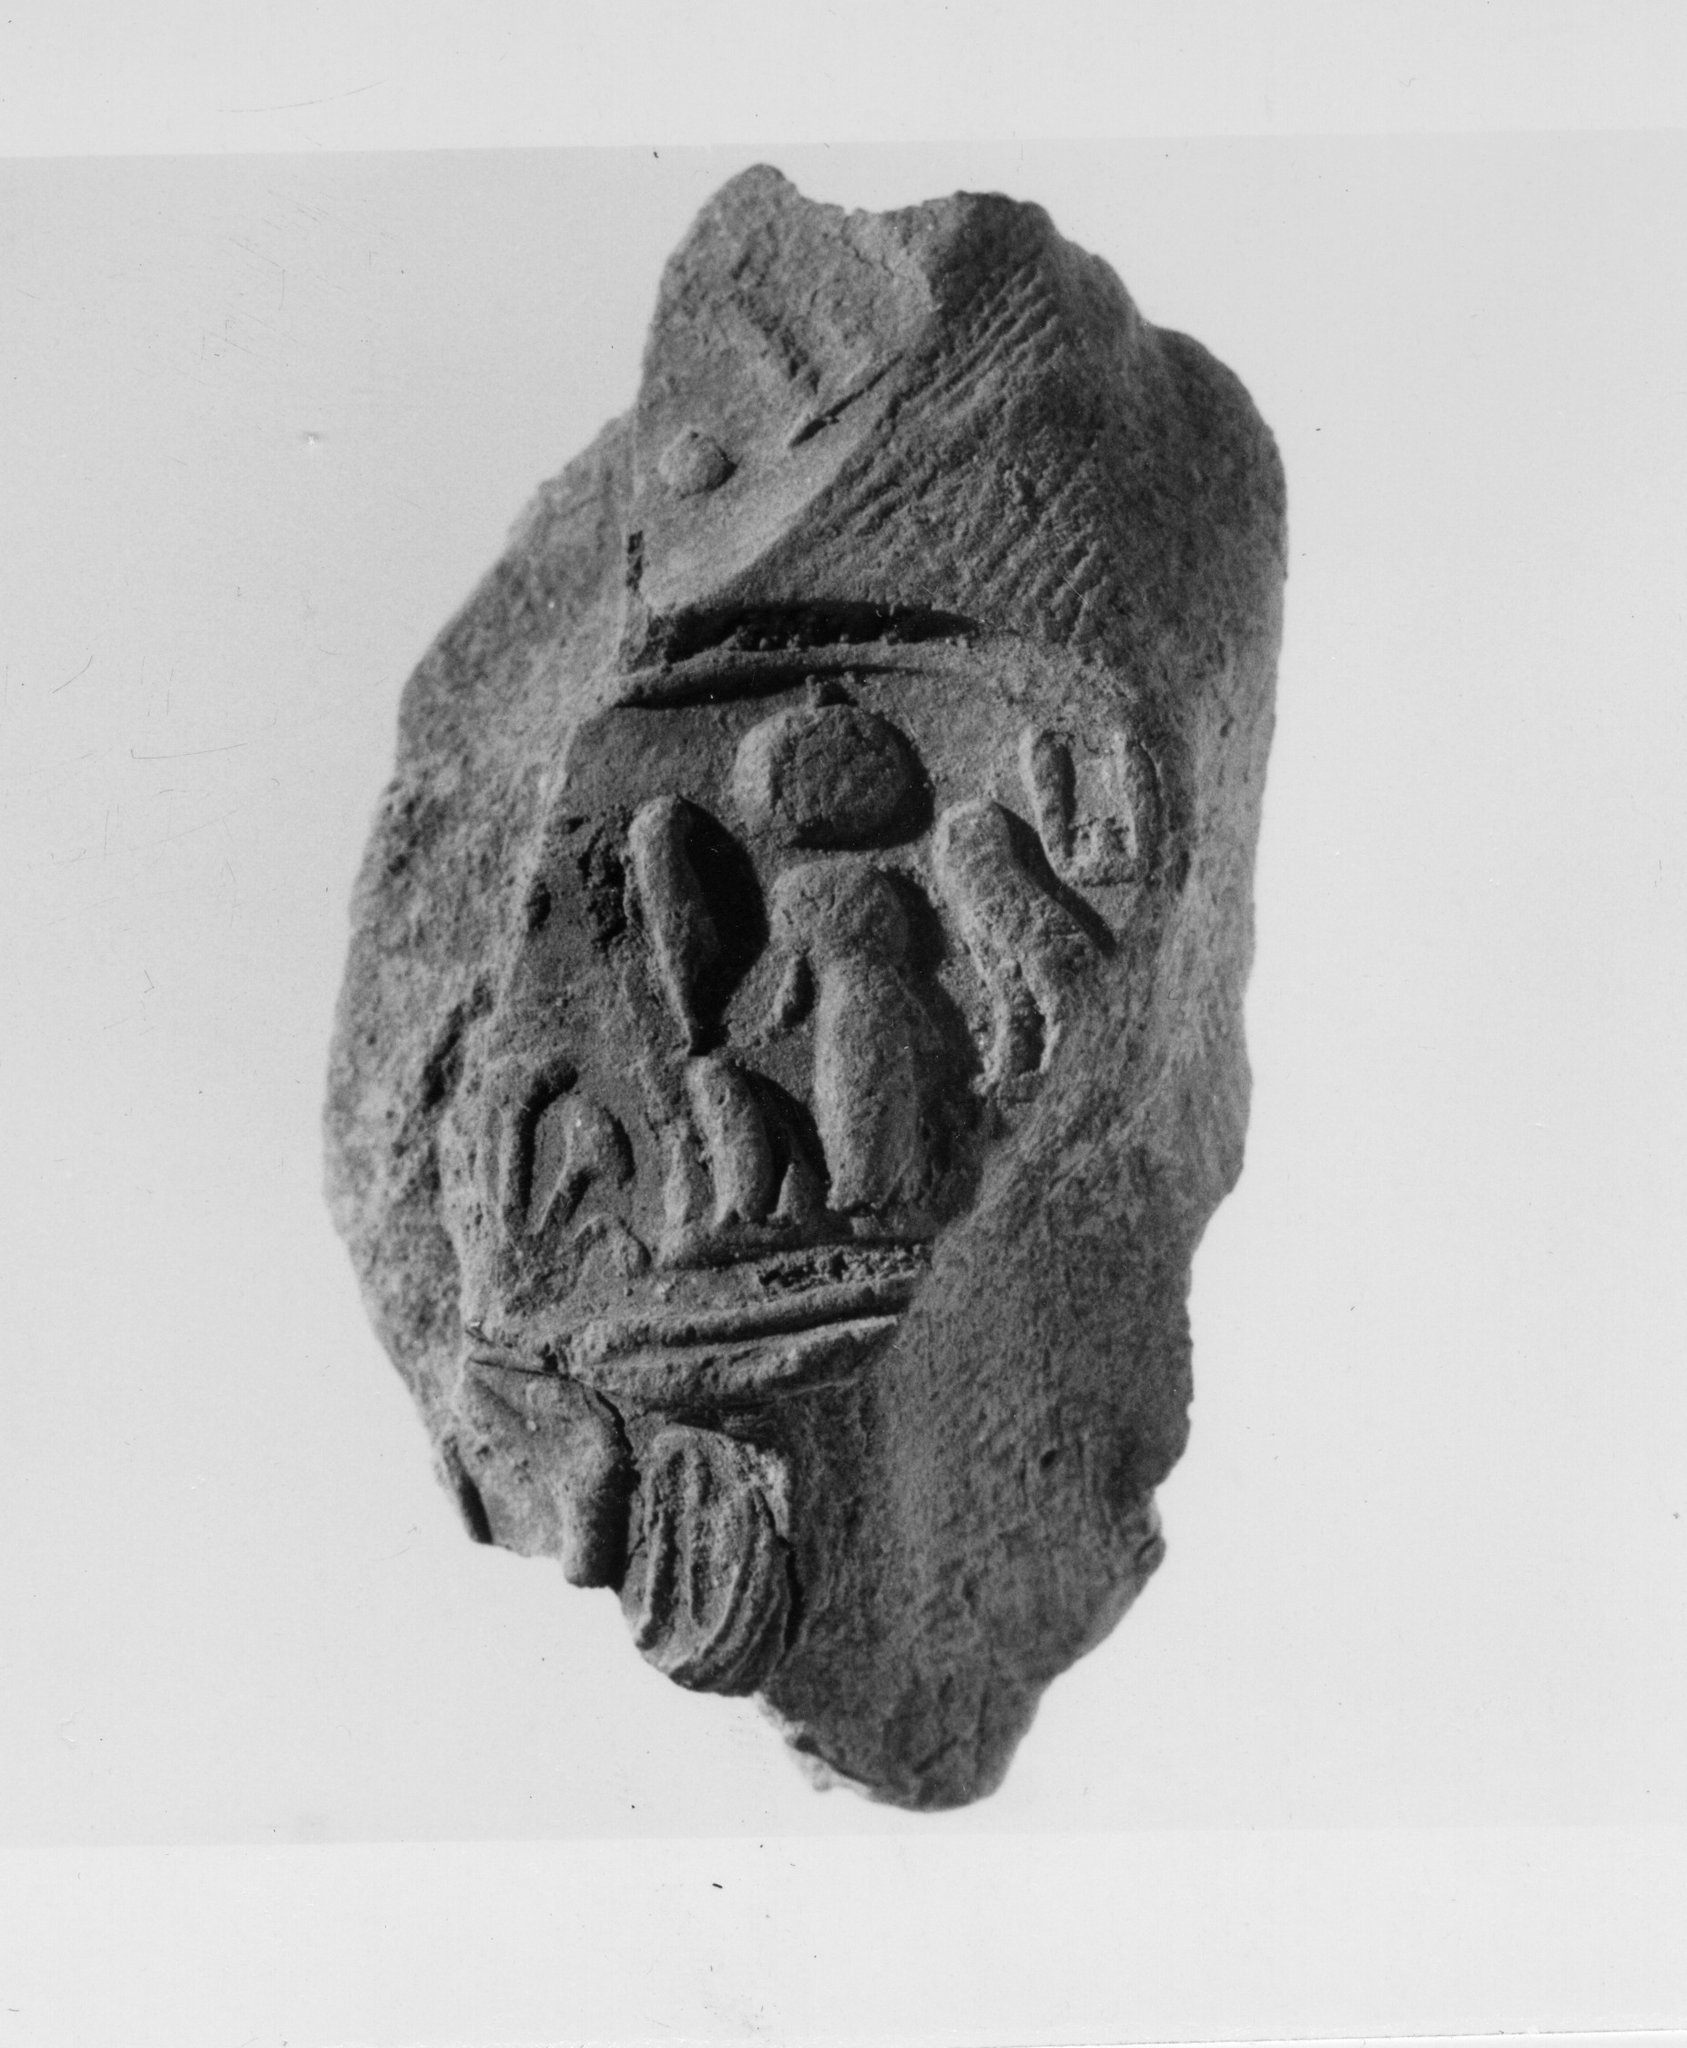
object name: sealing, amenhotep iii, nebmaatre, cobra,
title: Document Sealing With Multiple Seal Impressions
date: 1390-1352 BCE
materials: mud